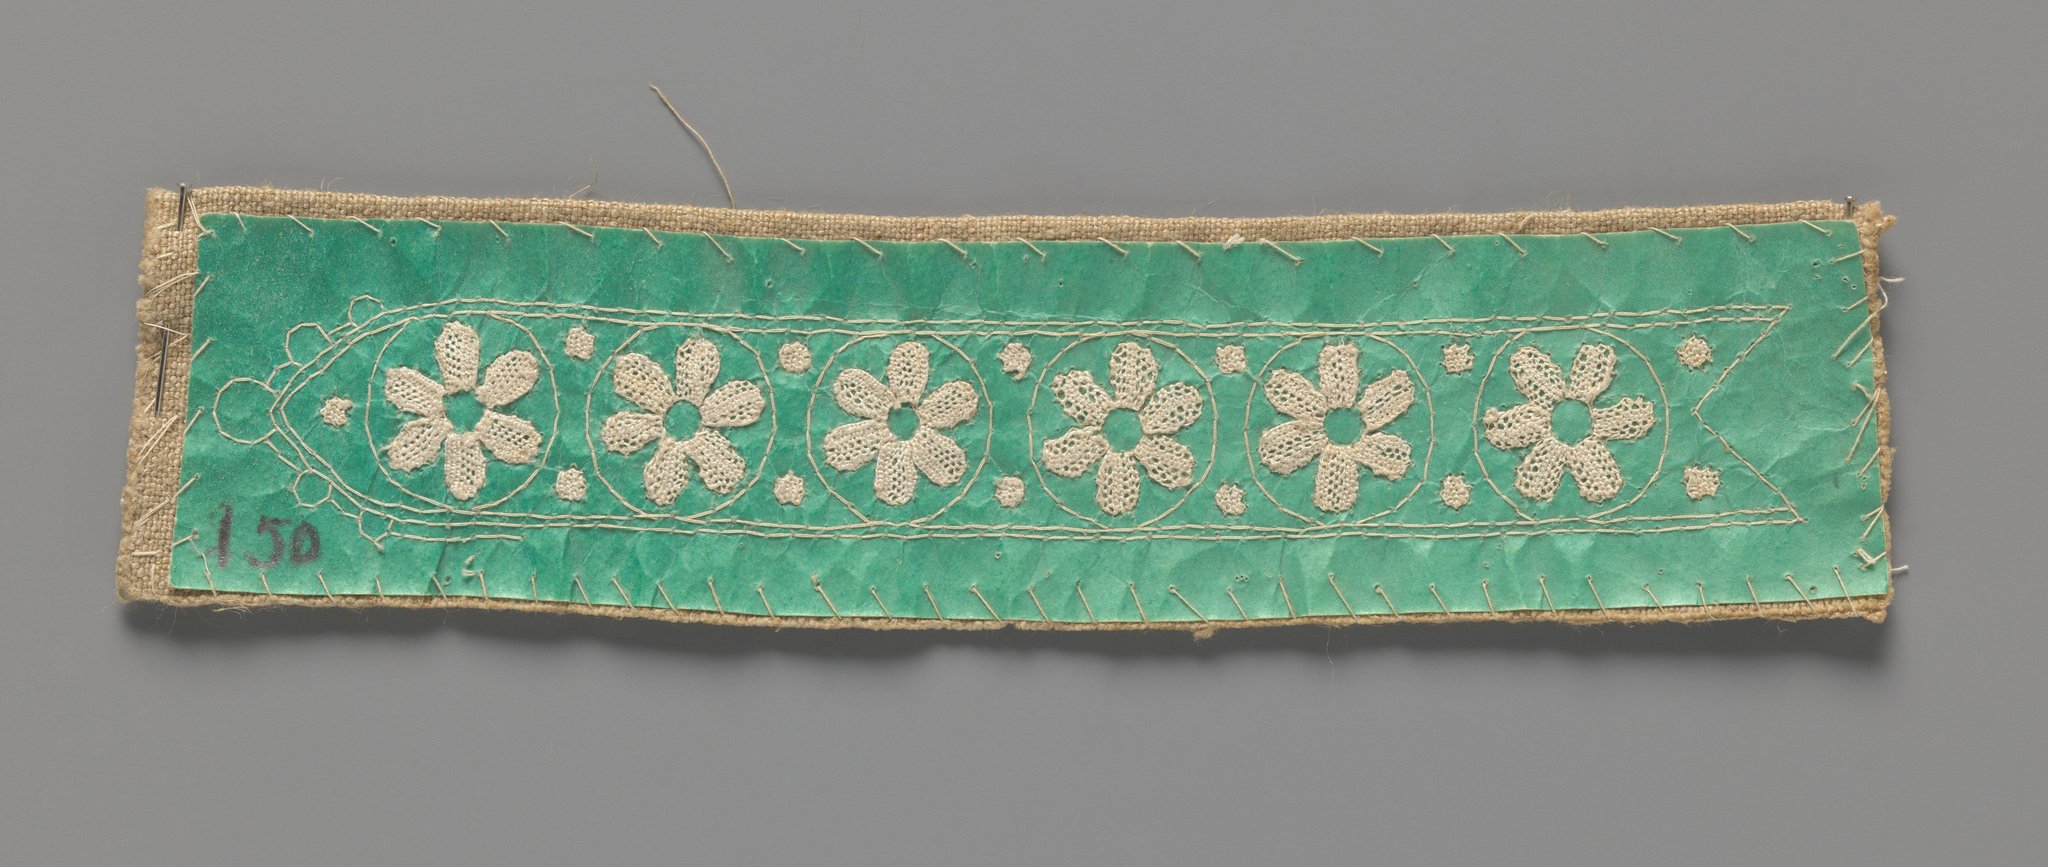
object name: werkstuk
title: Gereedschap voor een naaldkantmotief in de vorm van kleermakerslinnen waarop groen perkament is genaaid met witte traceerdraden in boekenleggervorm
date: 1906-1910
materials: linen, parchment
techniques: sewing, weave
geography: the hague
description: Gereedschap voor een naaldkantmotief in de vorm van dubbel kleermakerslinnen waarop groen perkament is genaaid. Op het perkament is met witte traceerdraden een sierband gemaakt met zes rozetbloemen op een rij, elk met zes bloemblaadjes en gevat in een cirkel. Tussen de opeenvolgende cirkels staan steeds twee stippen. Het werkstuk in wording lijkt een boekenlegger, met aan het ene uiteinde een punt en aan het andere uiteinde een zwaluwstaart. De rozetbloemen en stippen zijn reeds gevuld met een variatie aan festonsteken. Op het perkament staat geschreven met potlood: "1,50".